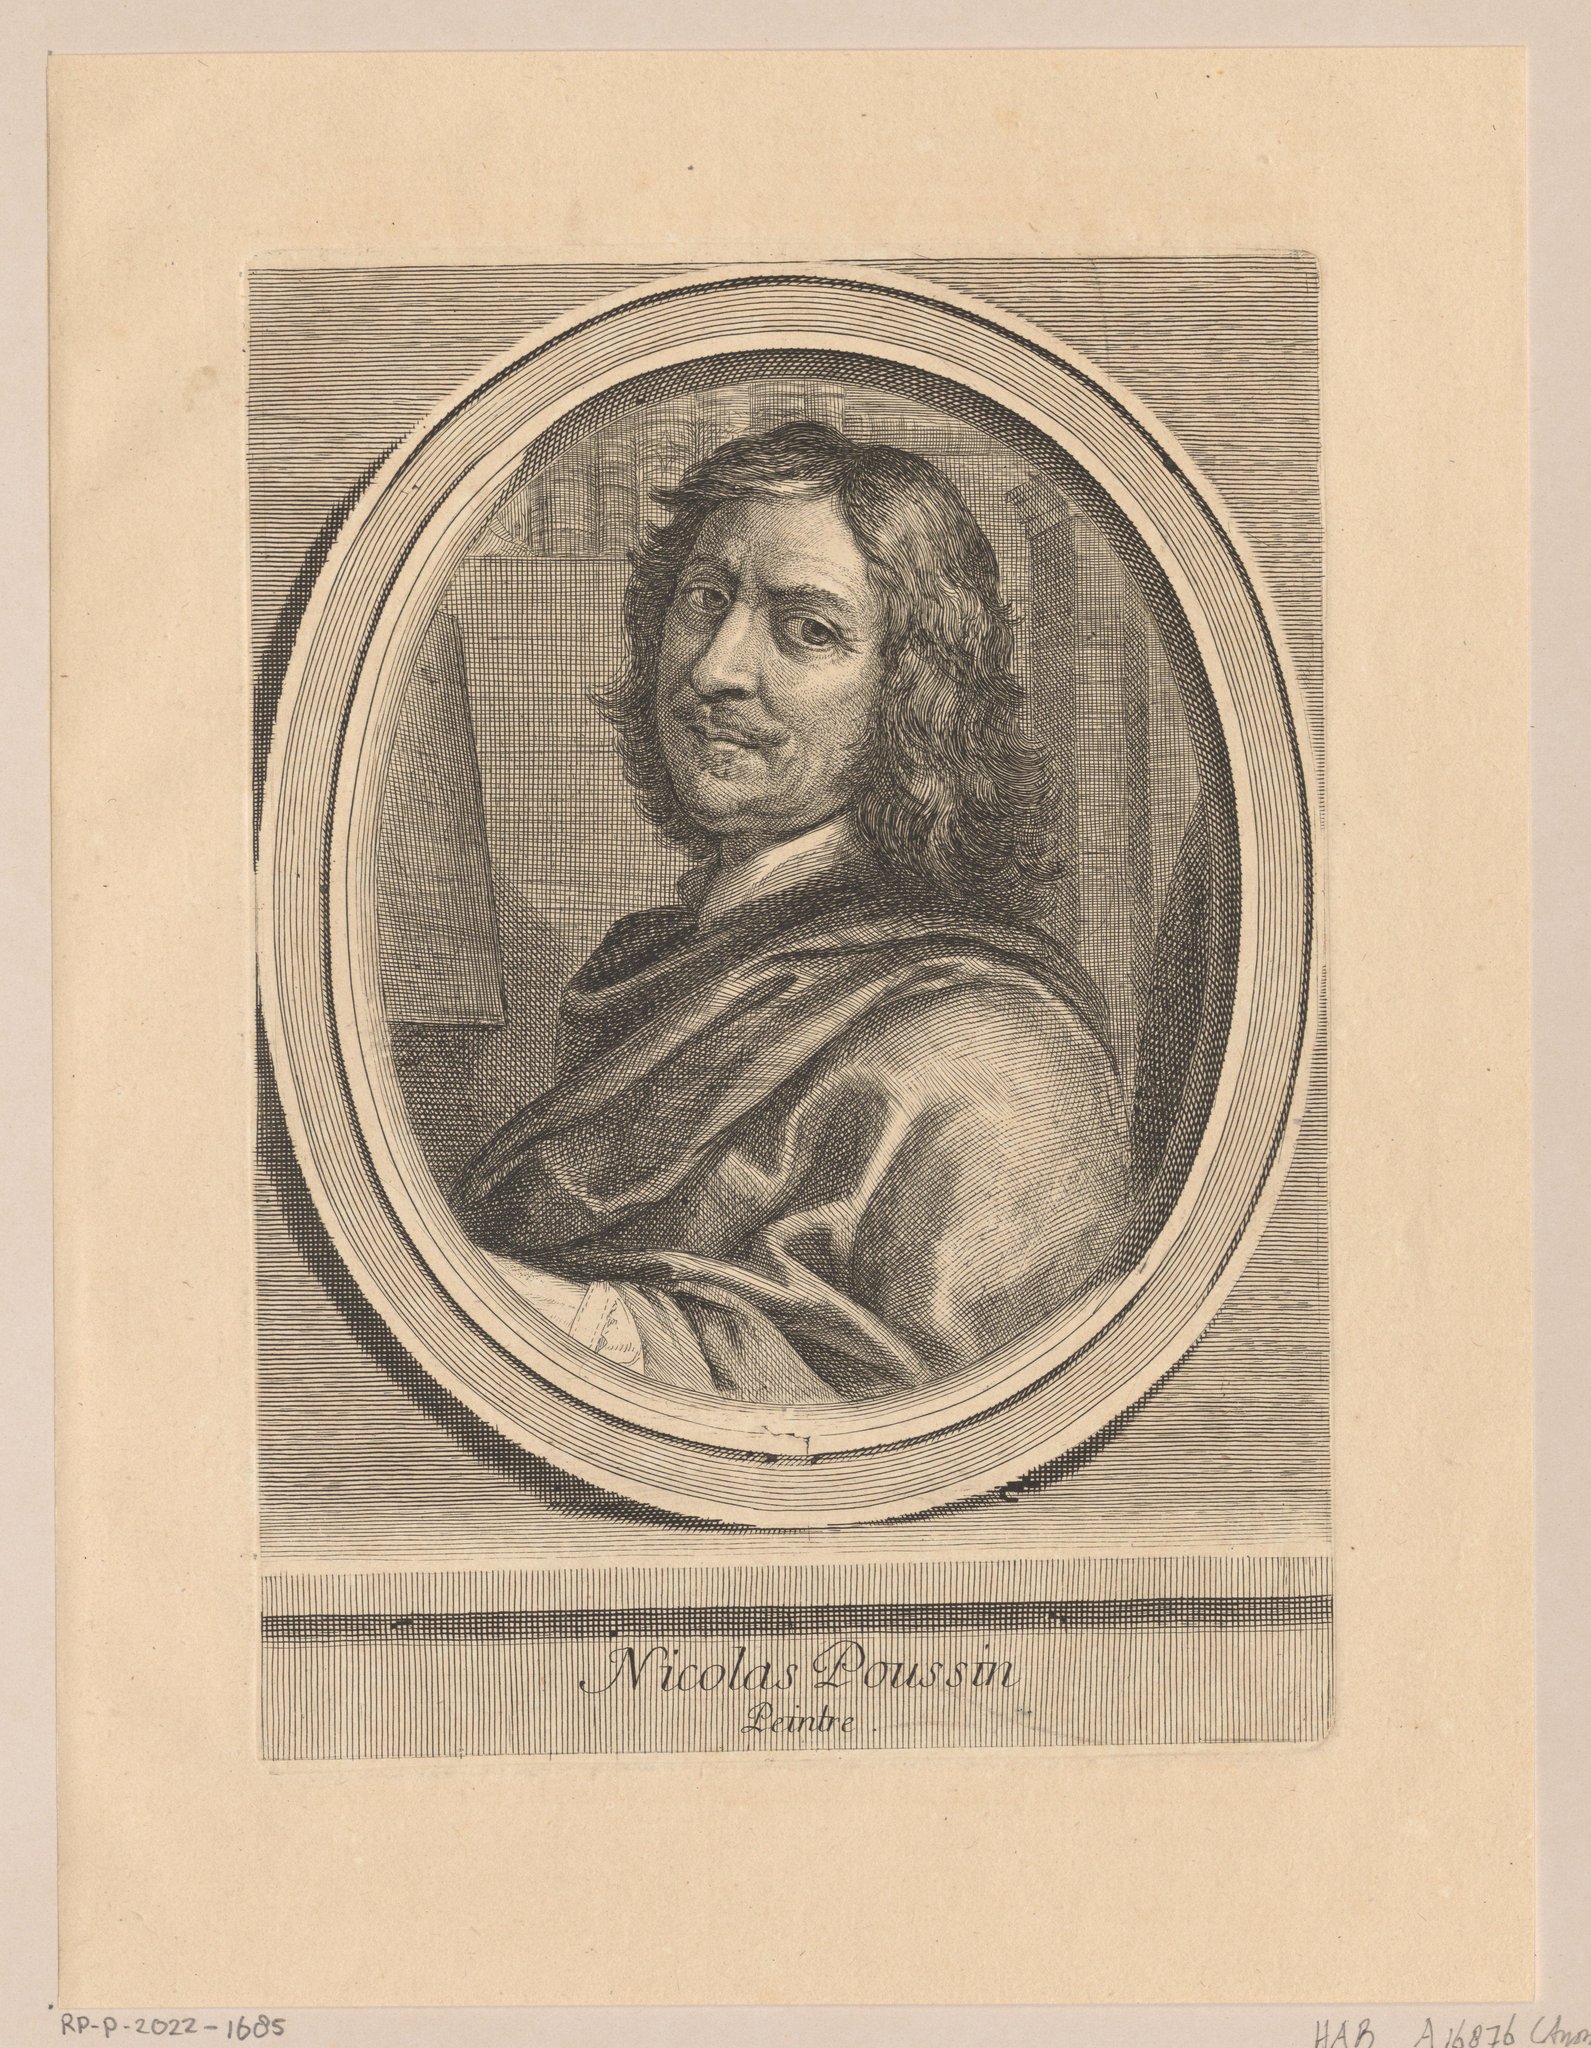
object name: print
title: Portret van Nicolas Poussin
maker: Anonymous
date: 1696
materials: paper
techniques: engraving, etching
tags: rome, painter, draughtsman, nicolas poussin, historical persons, portrait, self-portrait of painter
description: Prent waarschijnlijk uit: Perrault, Charles. Les hommes illustres qui ont paru en France pendant ce siecle (...). Parijs: Antoine Dezaillier, 1696.